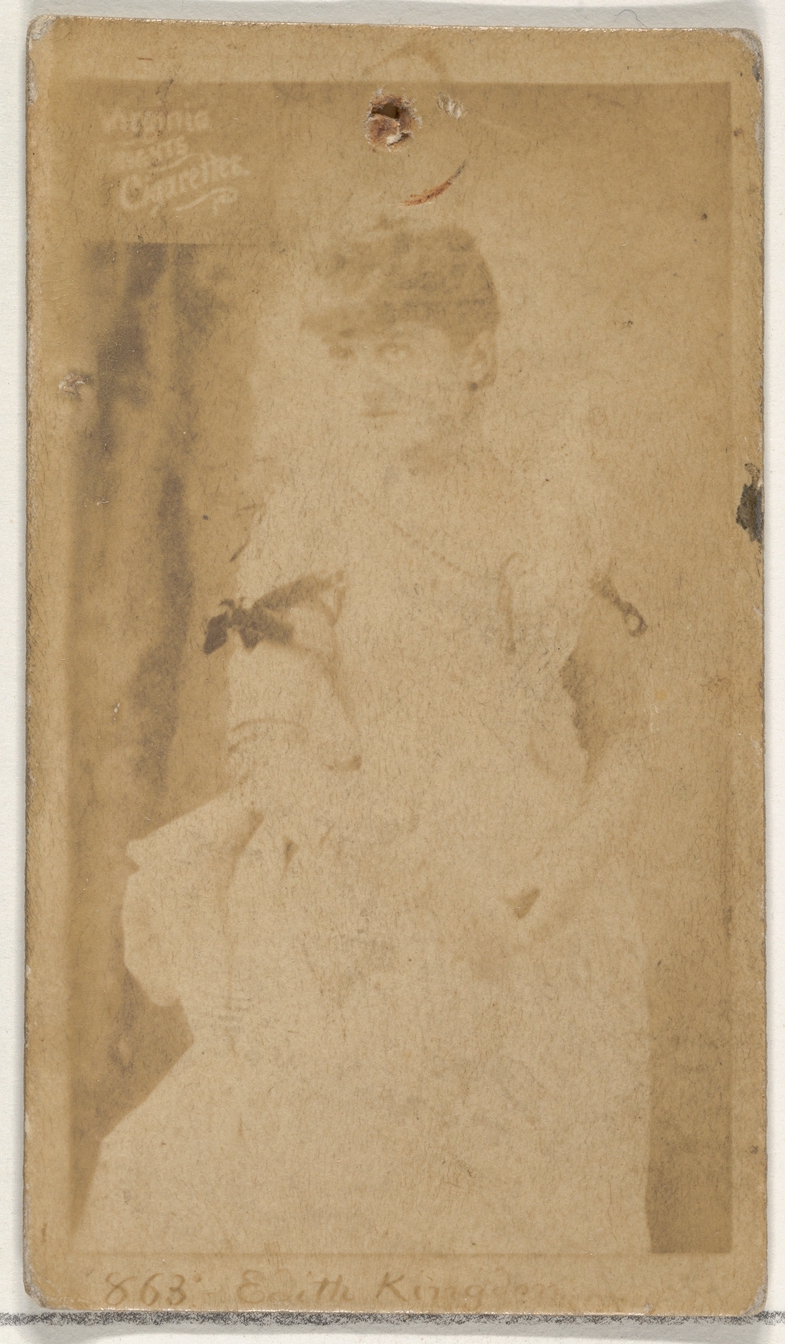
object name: photograph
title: Card 868, Edith Kingdon, from the Actors and Actresses series (N45, Type 2) for Virginia Brights Cigarettes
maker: allen & ginter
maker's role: publisher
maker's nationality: american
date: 1888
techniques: albumen silver print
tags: portraits,women,actresses